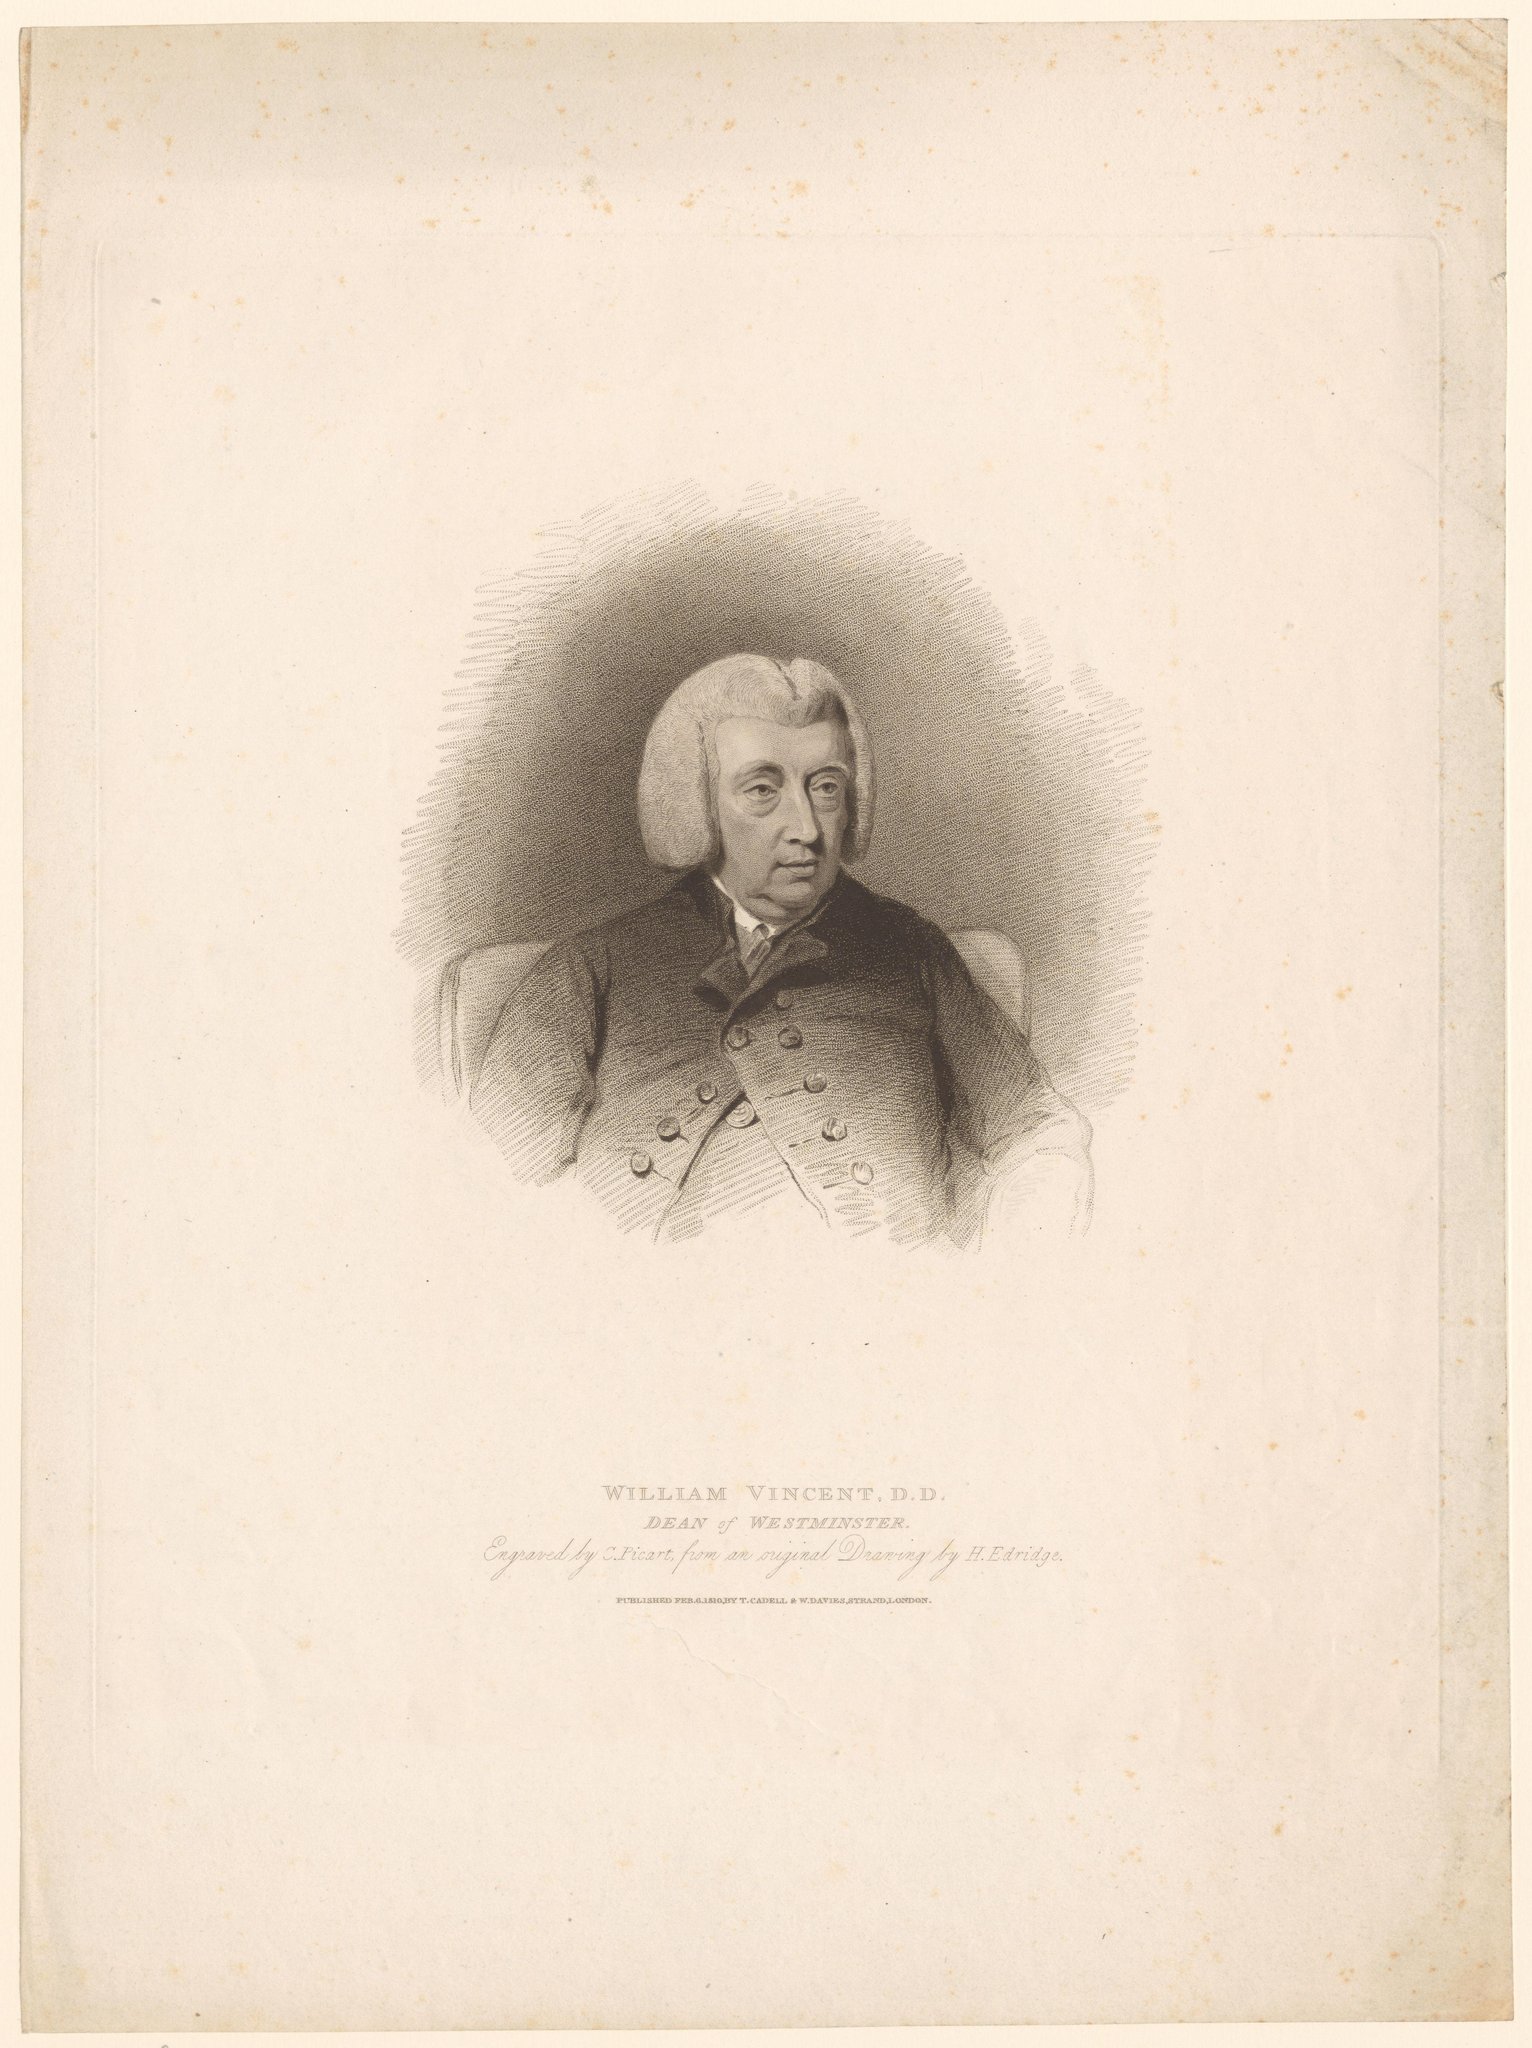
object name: print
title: The British Gallery of Contemporary Portraits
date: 1802-1810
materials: paper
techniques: etching, roulette, engraving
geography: london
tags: priest, priest (roman catholic), historical persons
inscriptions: collector's mark: Lugt 2228